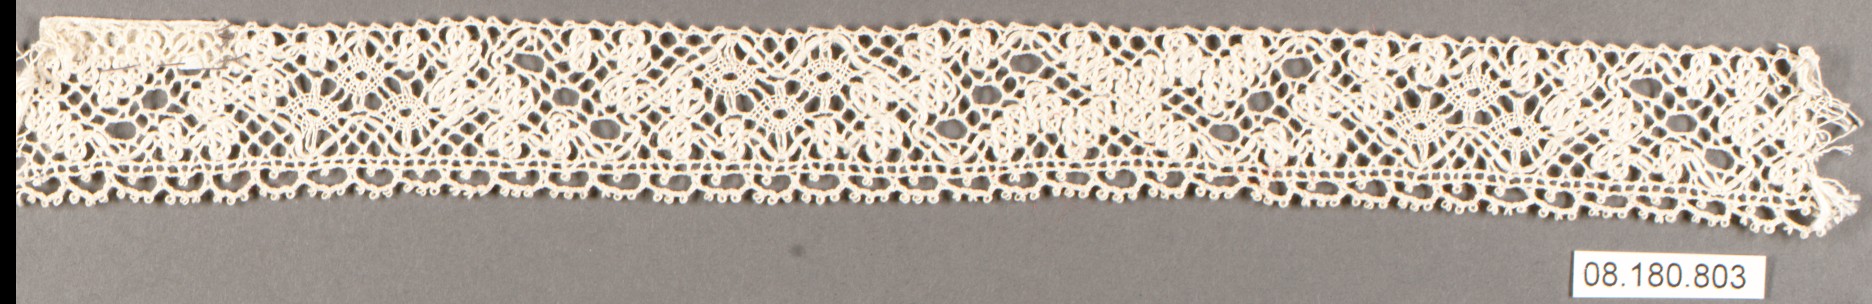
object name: fragment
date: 1801-1900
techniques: lace